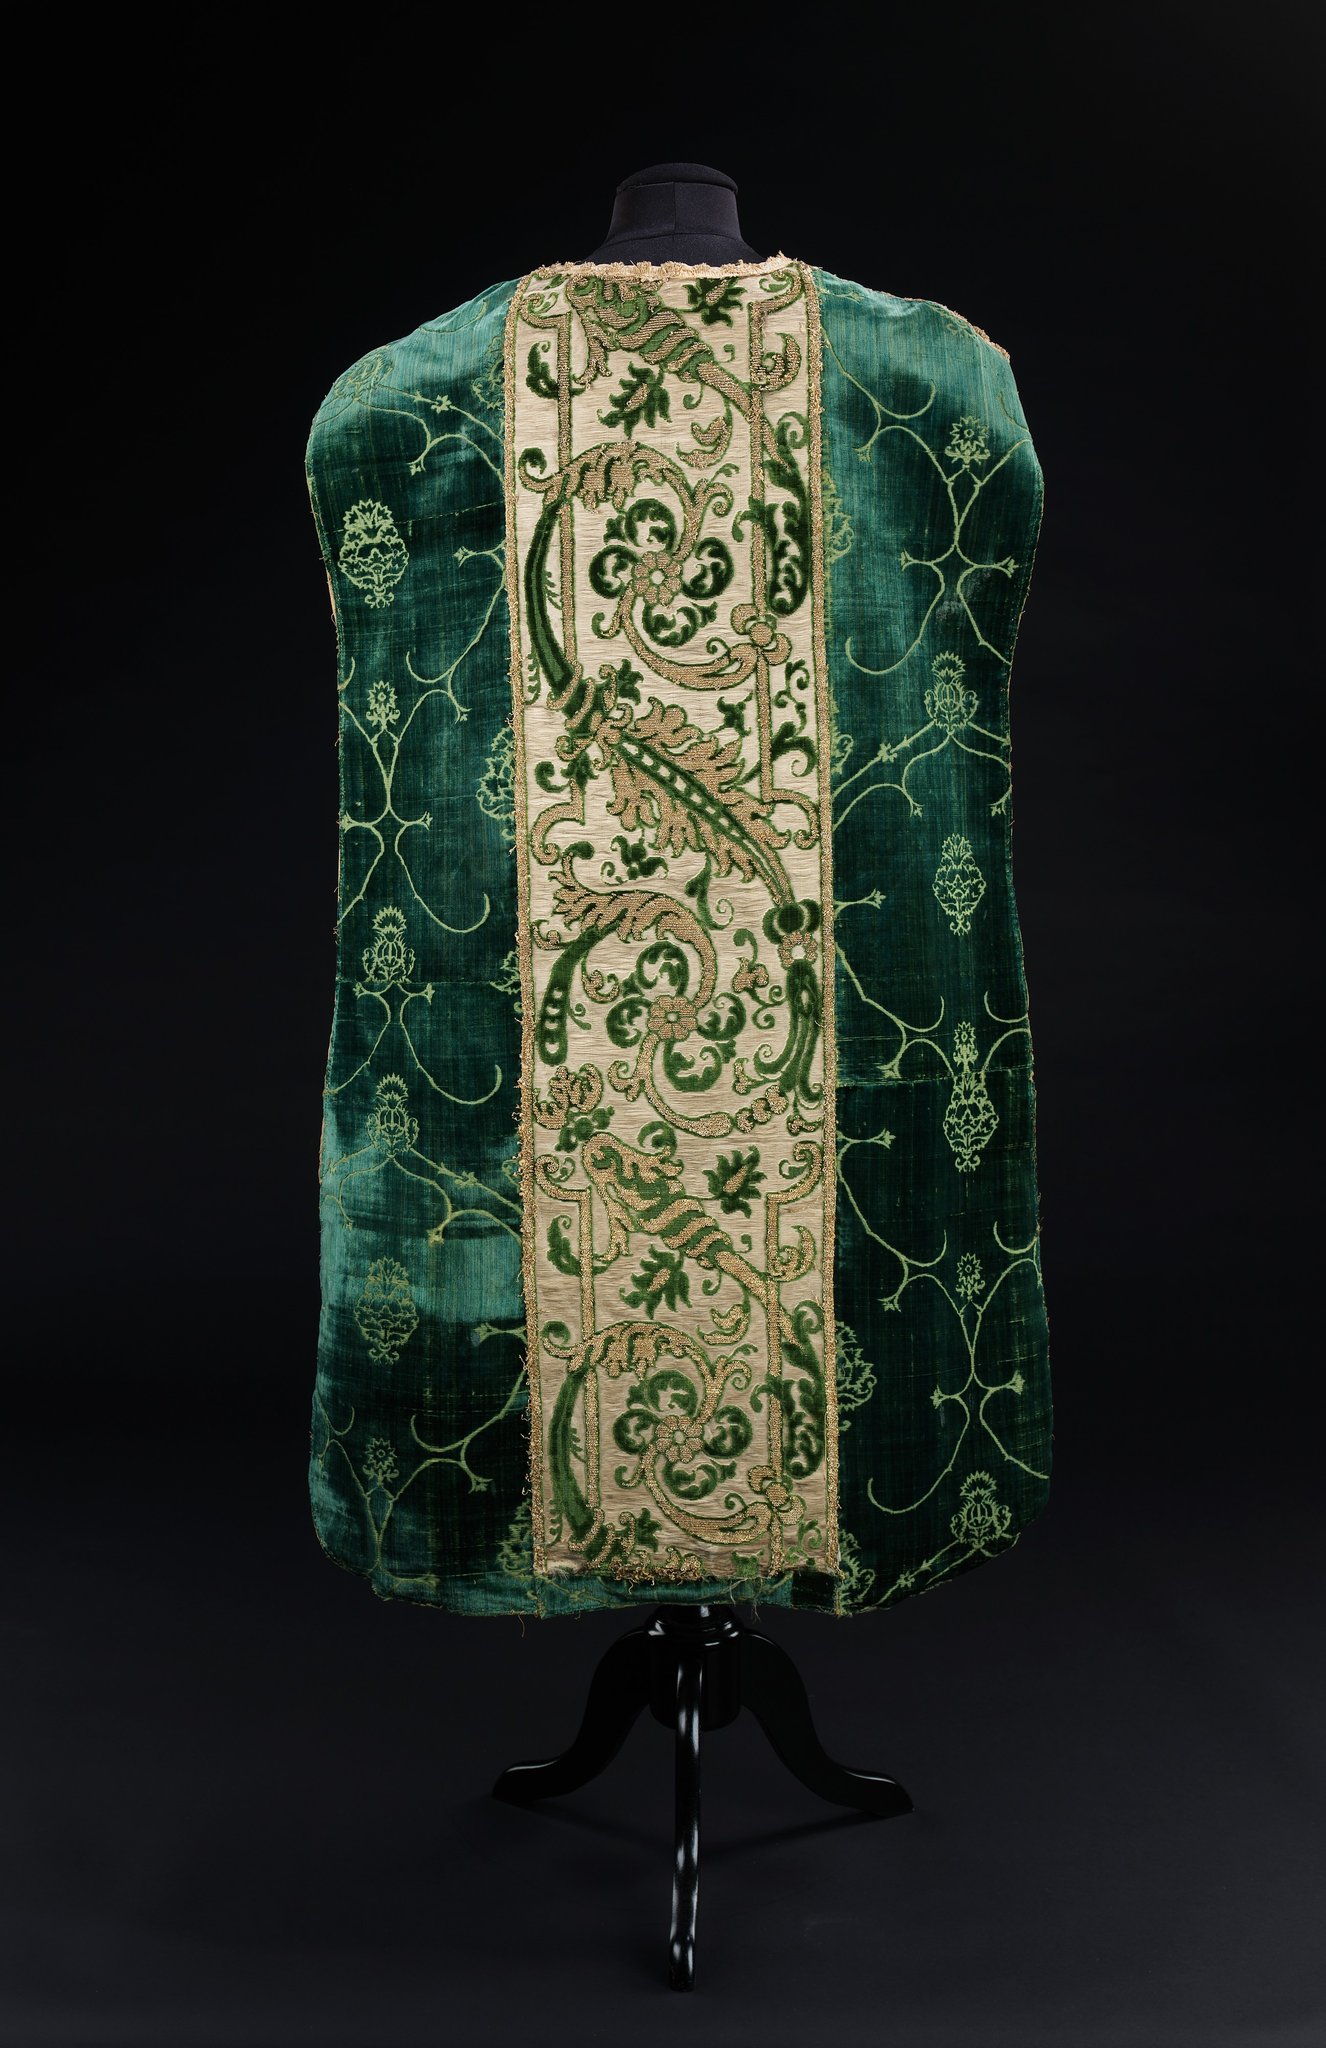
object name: chasuble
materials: metal, silk